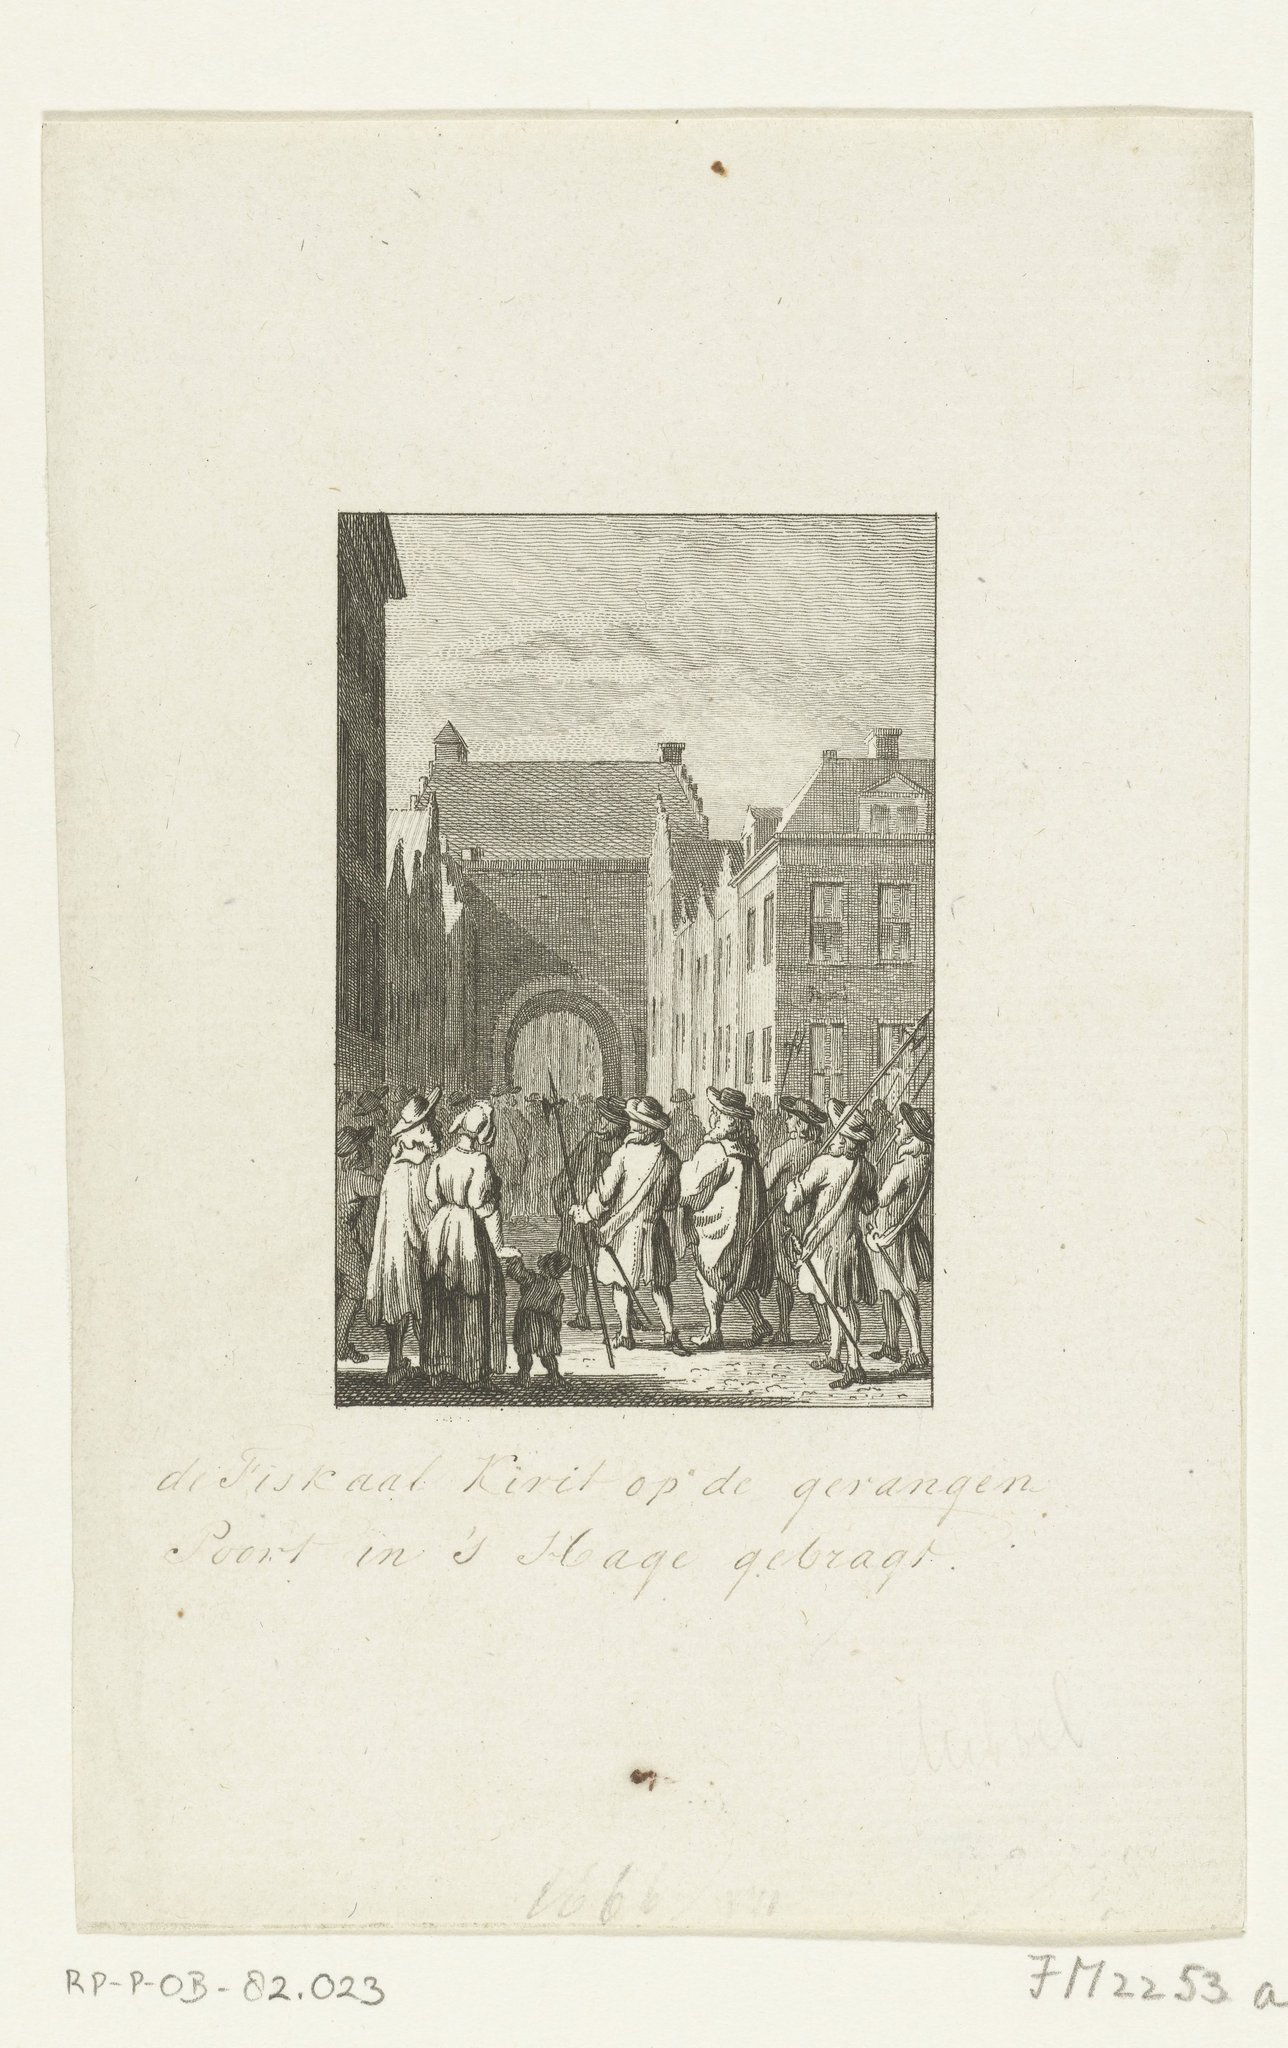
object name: history print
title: De advocaat-fiscaal Kievit wordt naar de Gevangenpoort gebracht, 1686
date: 1780-1795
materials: paper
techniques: etching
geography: northern netherlands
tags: rotterdam, transport (of arrested person)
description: Gebruikt als illustratie in: J. Fokke, Geschiedenissen der Vereenigde Nederlanden voor de vaderlandsche jeugd, Johannes Allart, Amsterdam 1783-1795, 25 delen, dl. X, pl. VII. Deze plaat behoort bij de prenten over het jaar 1686.